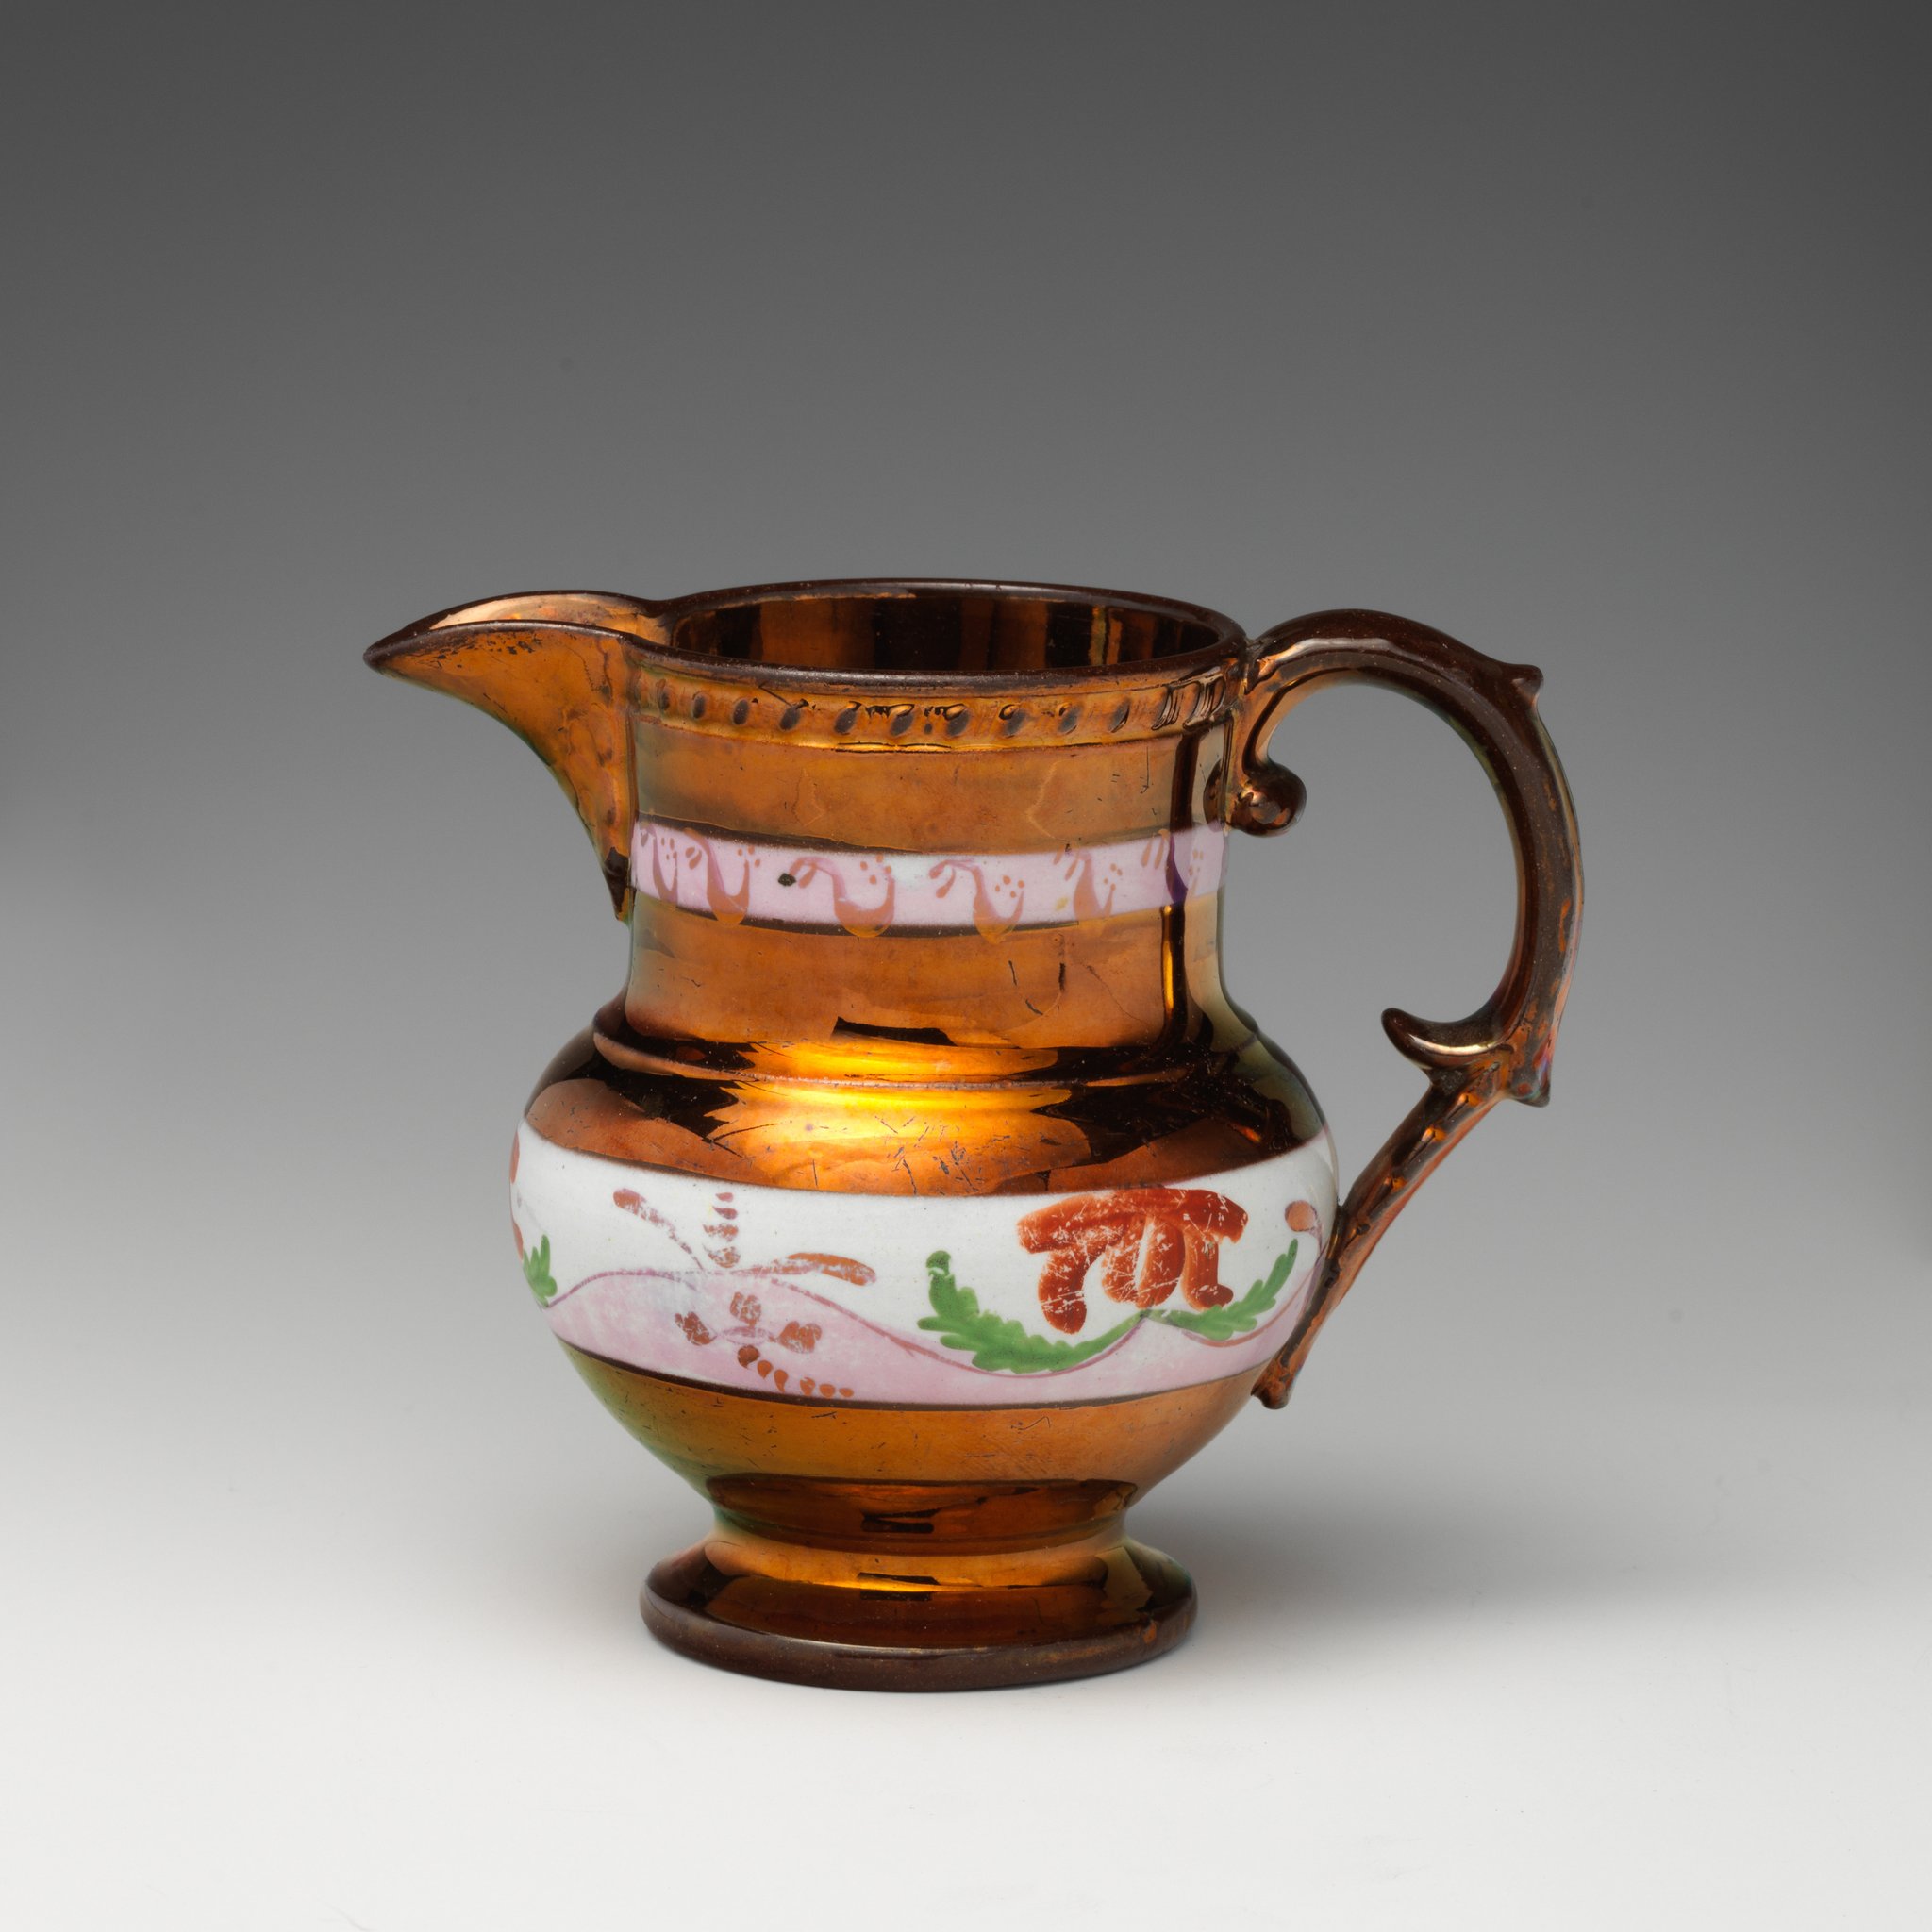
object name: pitcher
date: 1801-1900